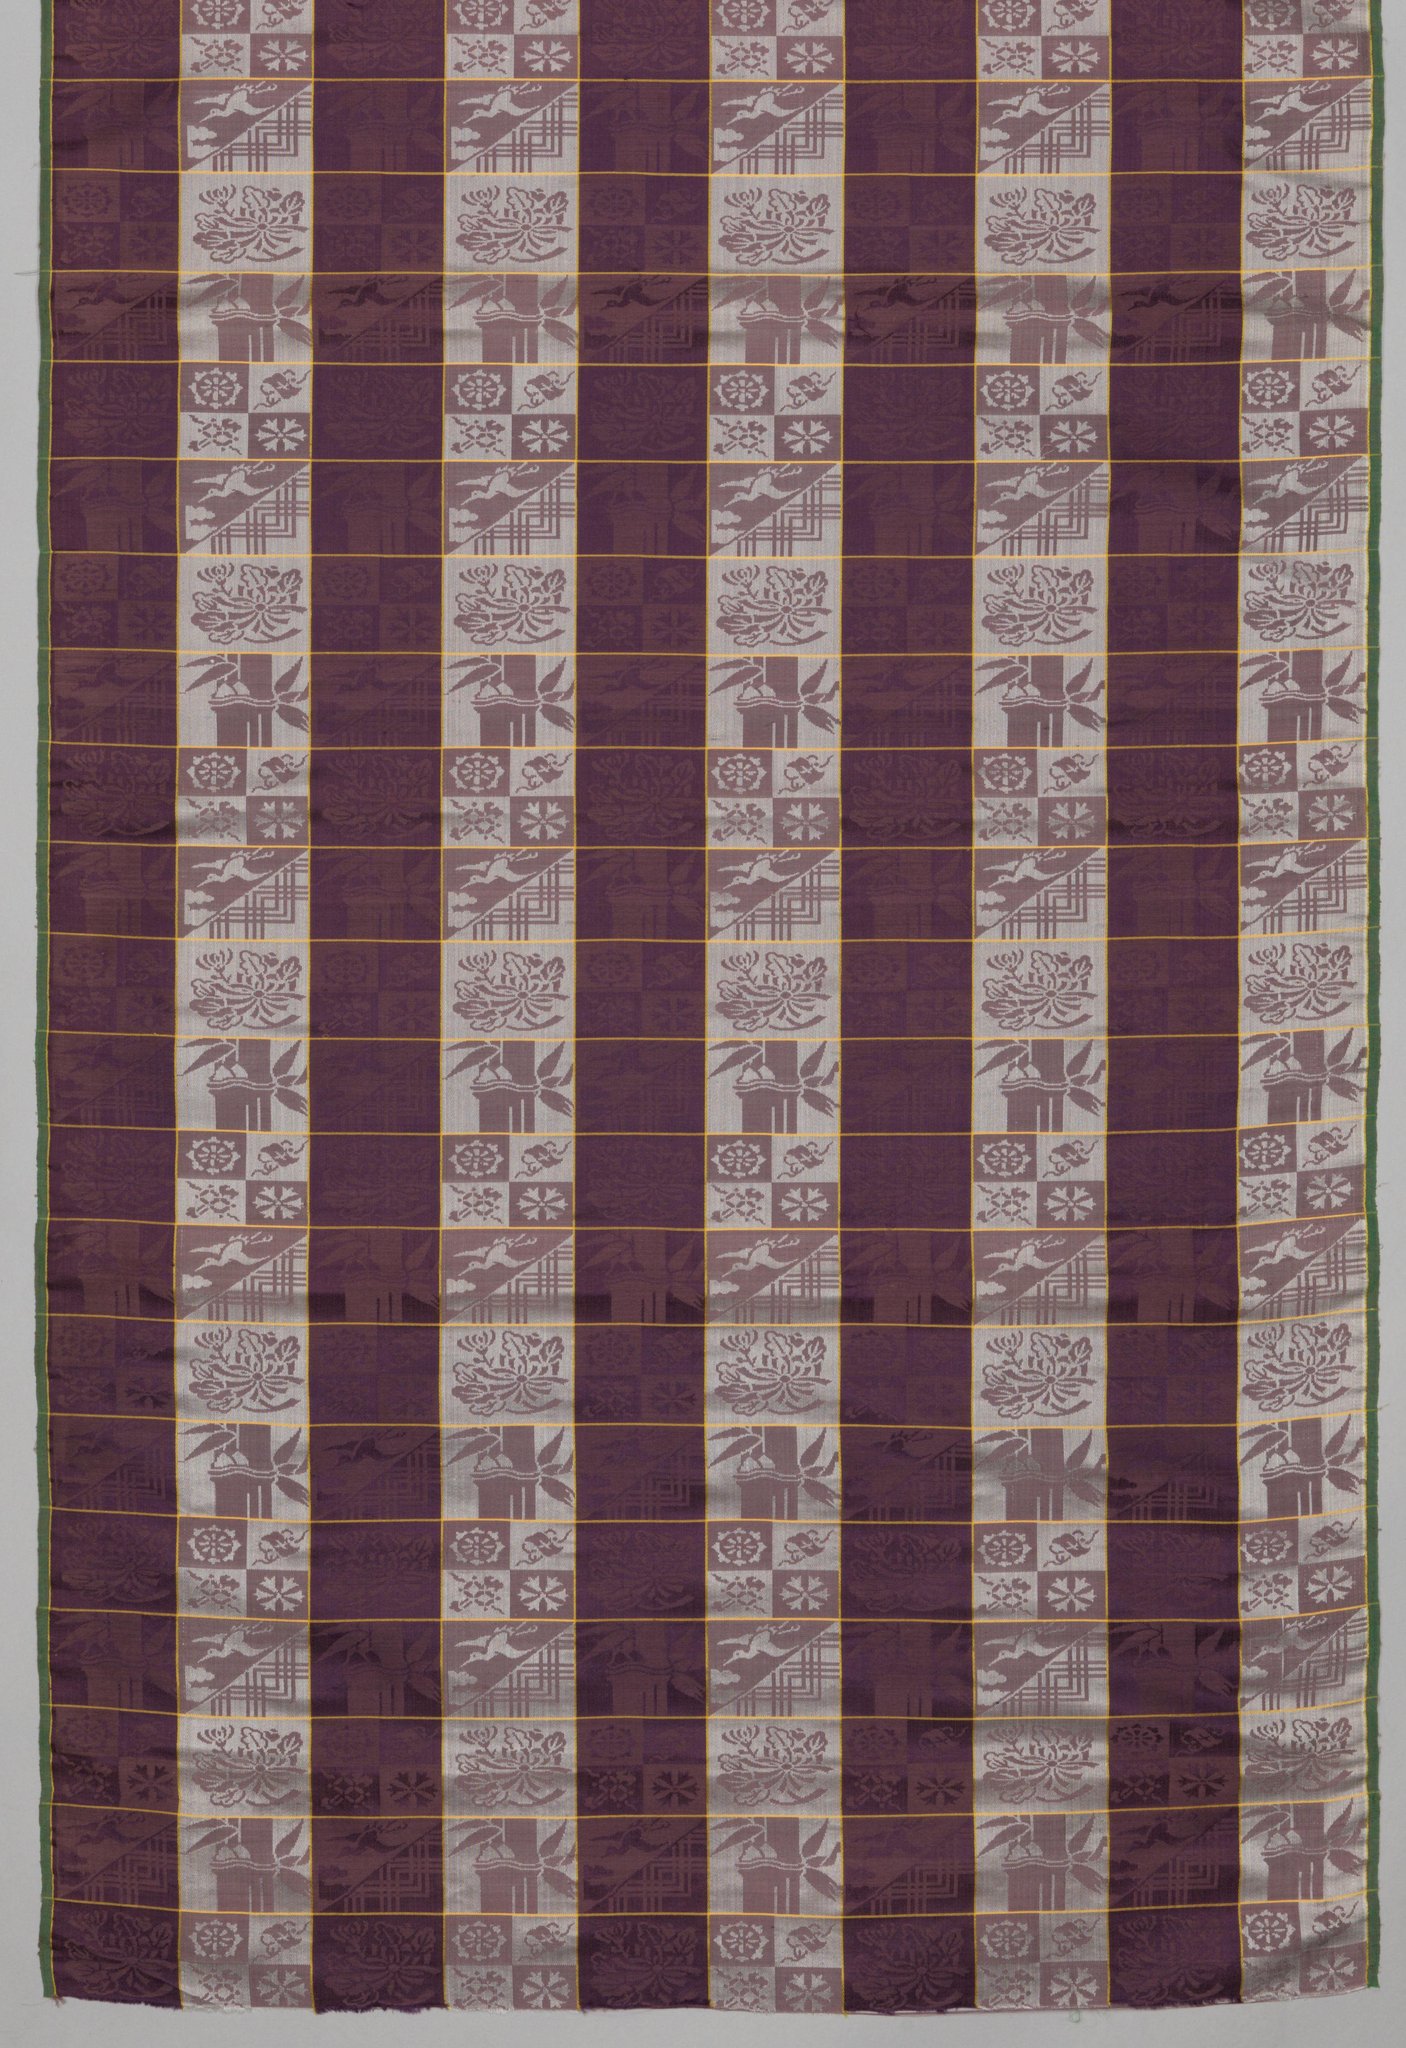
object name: textile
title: Baan zijdedamast met dessin van blokken, gekaderd door gele strepen in horizontale banen. De blokken zijn gevuld met diverse ornamenten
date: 1900-1920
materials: silk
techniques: damask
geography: japan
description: Baan zijdedamast met dessin van blokken, gekaderd door dunne gele strepen, in horizontale banen met een verspringend patroon binnen de blokken van om en om chrysant en vier symbolen, en bamboe en vogel gecombineerd met geyoekte strepen in de binnen driehoek; deze dessins in verticale kleurbanen van paars met aubergine en zilvergrijs met rozegrijs. Oosterse textiel.